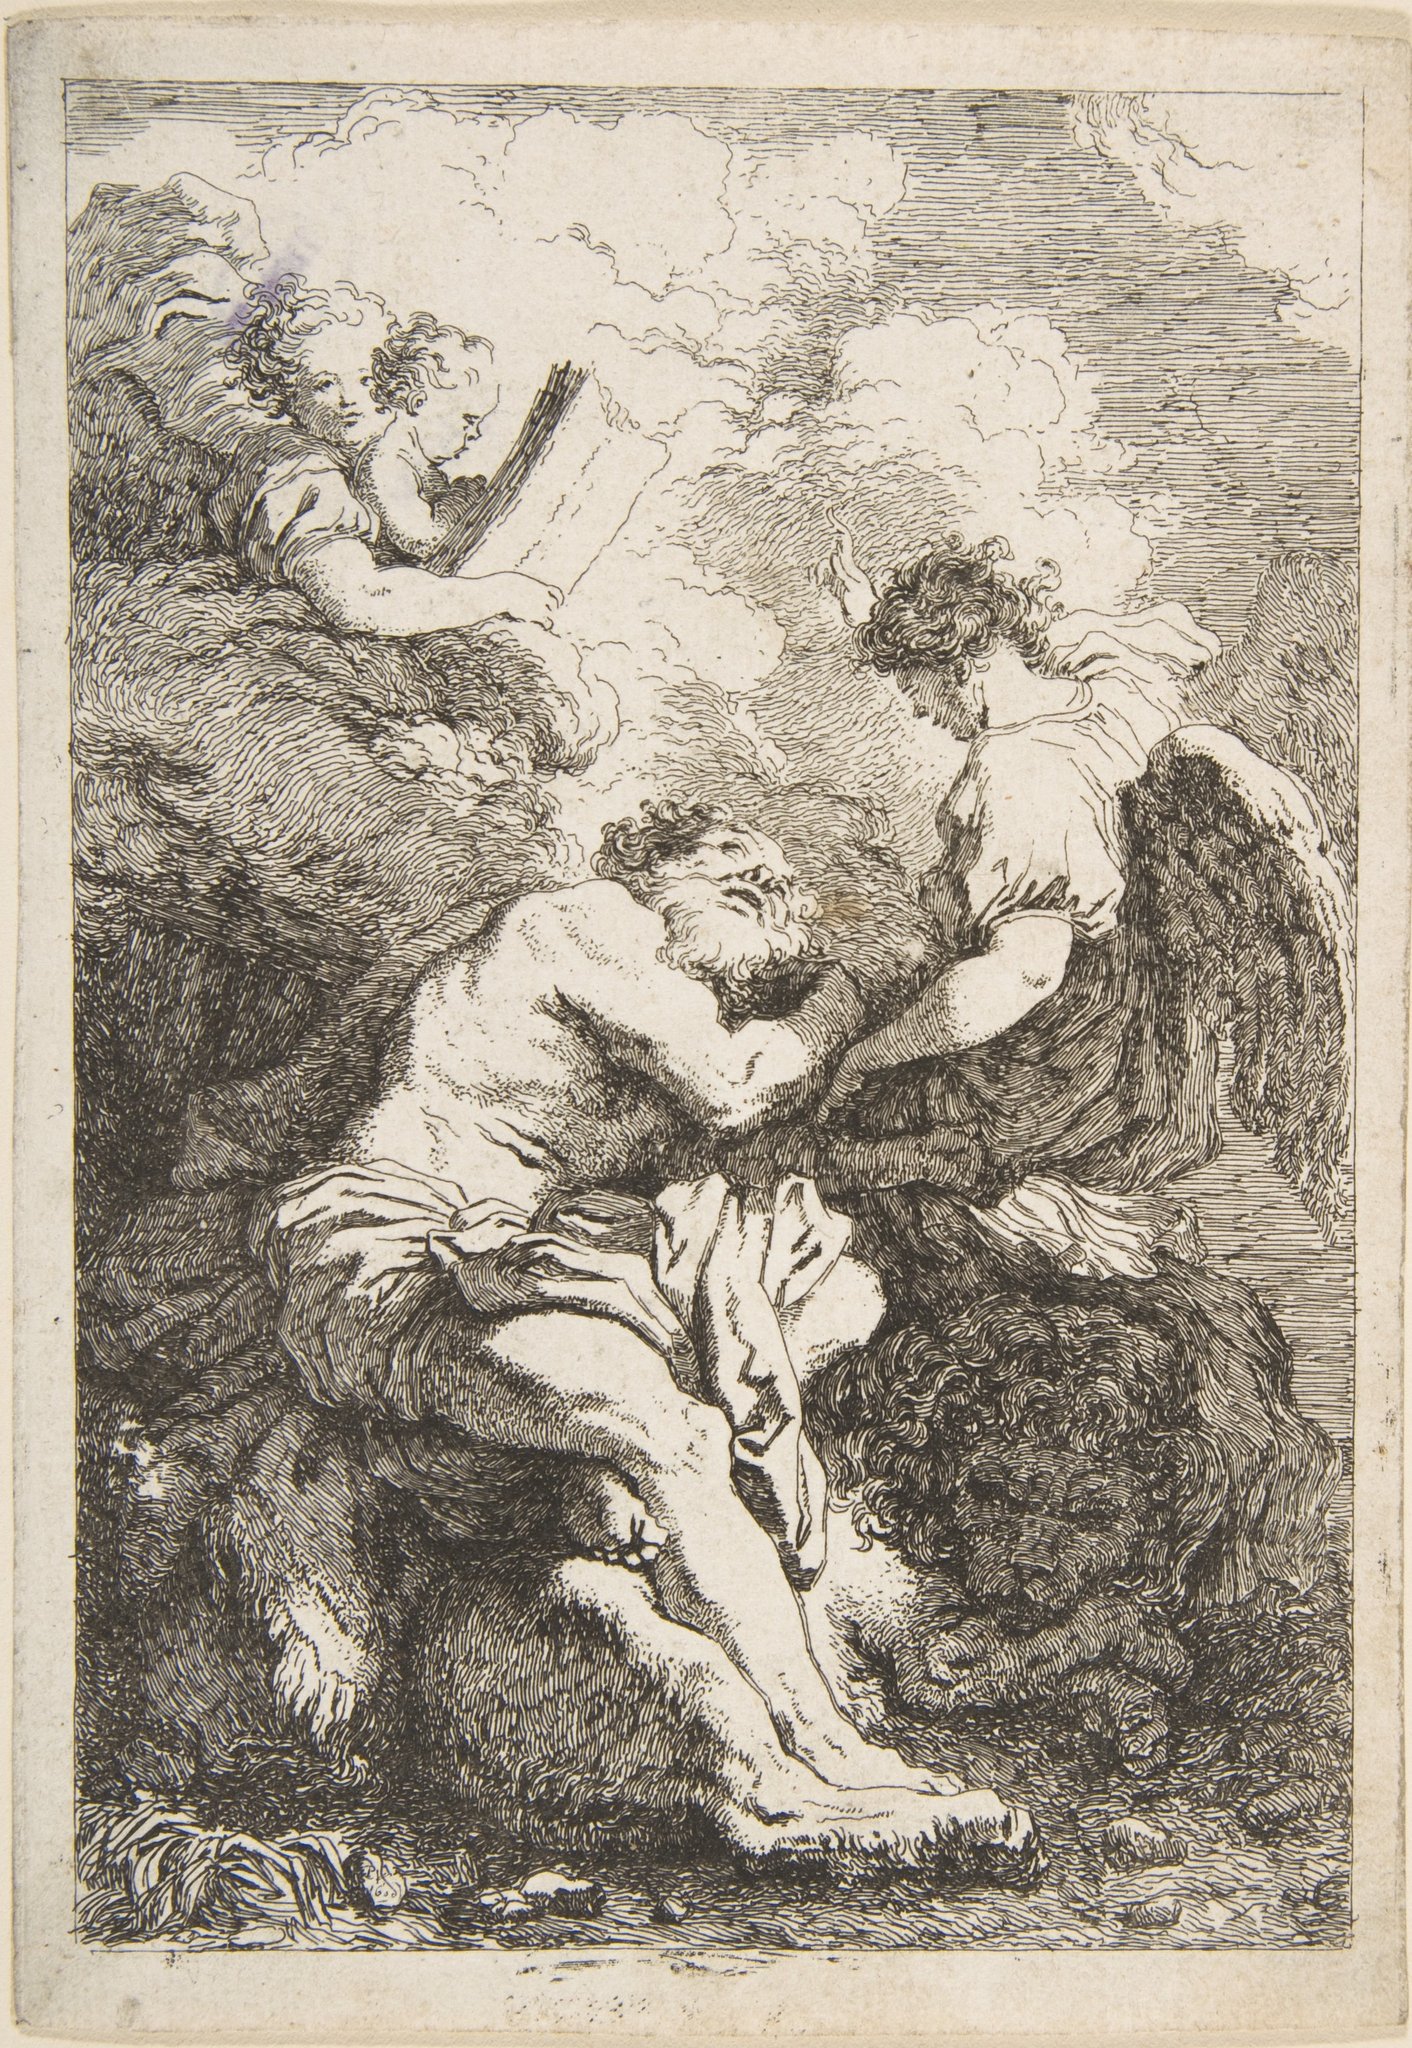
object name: print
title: The Vision of Saint Jerome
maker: jean honoré fragonard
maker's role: artist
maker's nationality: french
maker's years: 1732-1806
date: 1763-1764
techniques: etching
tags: infants,angels,saint jerome